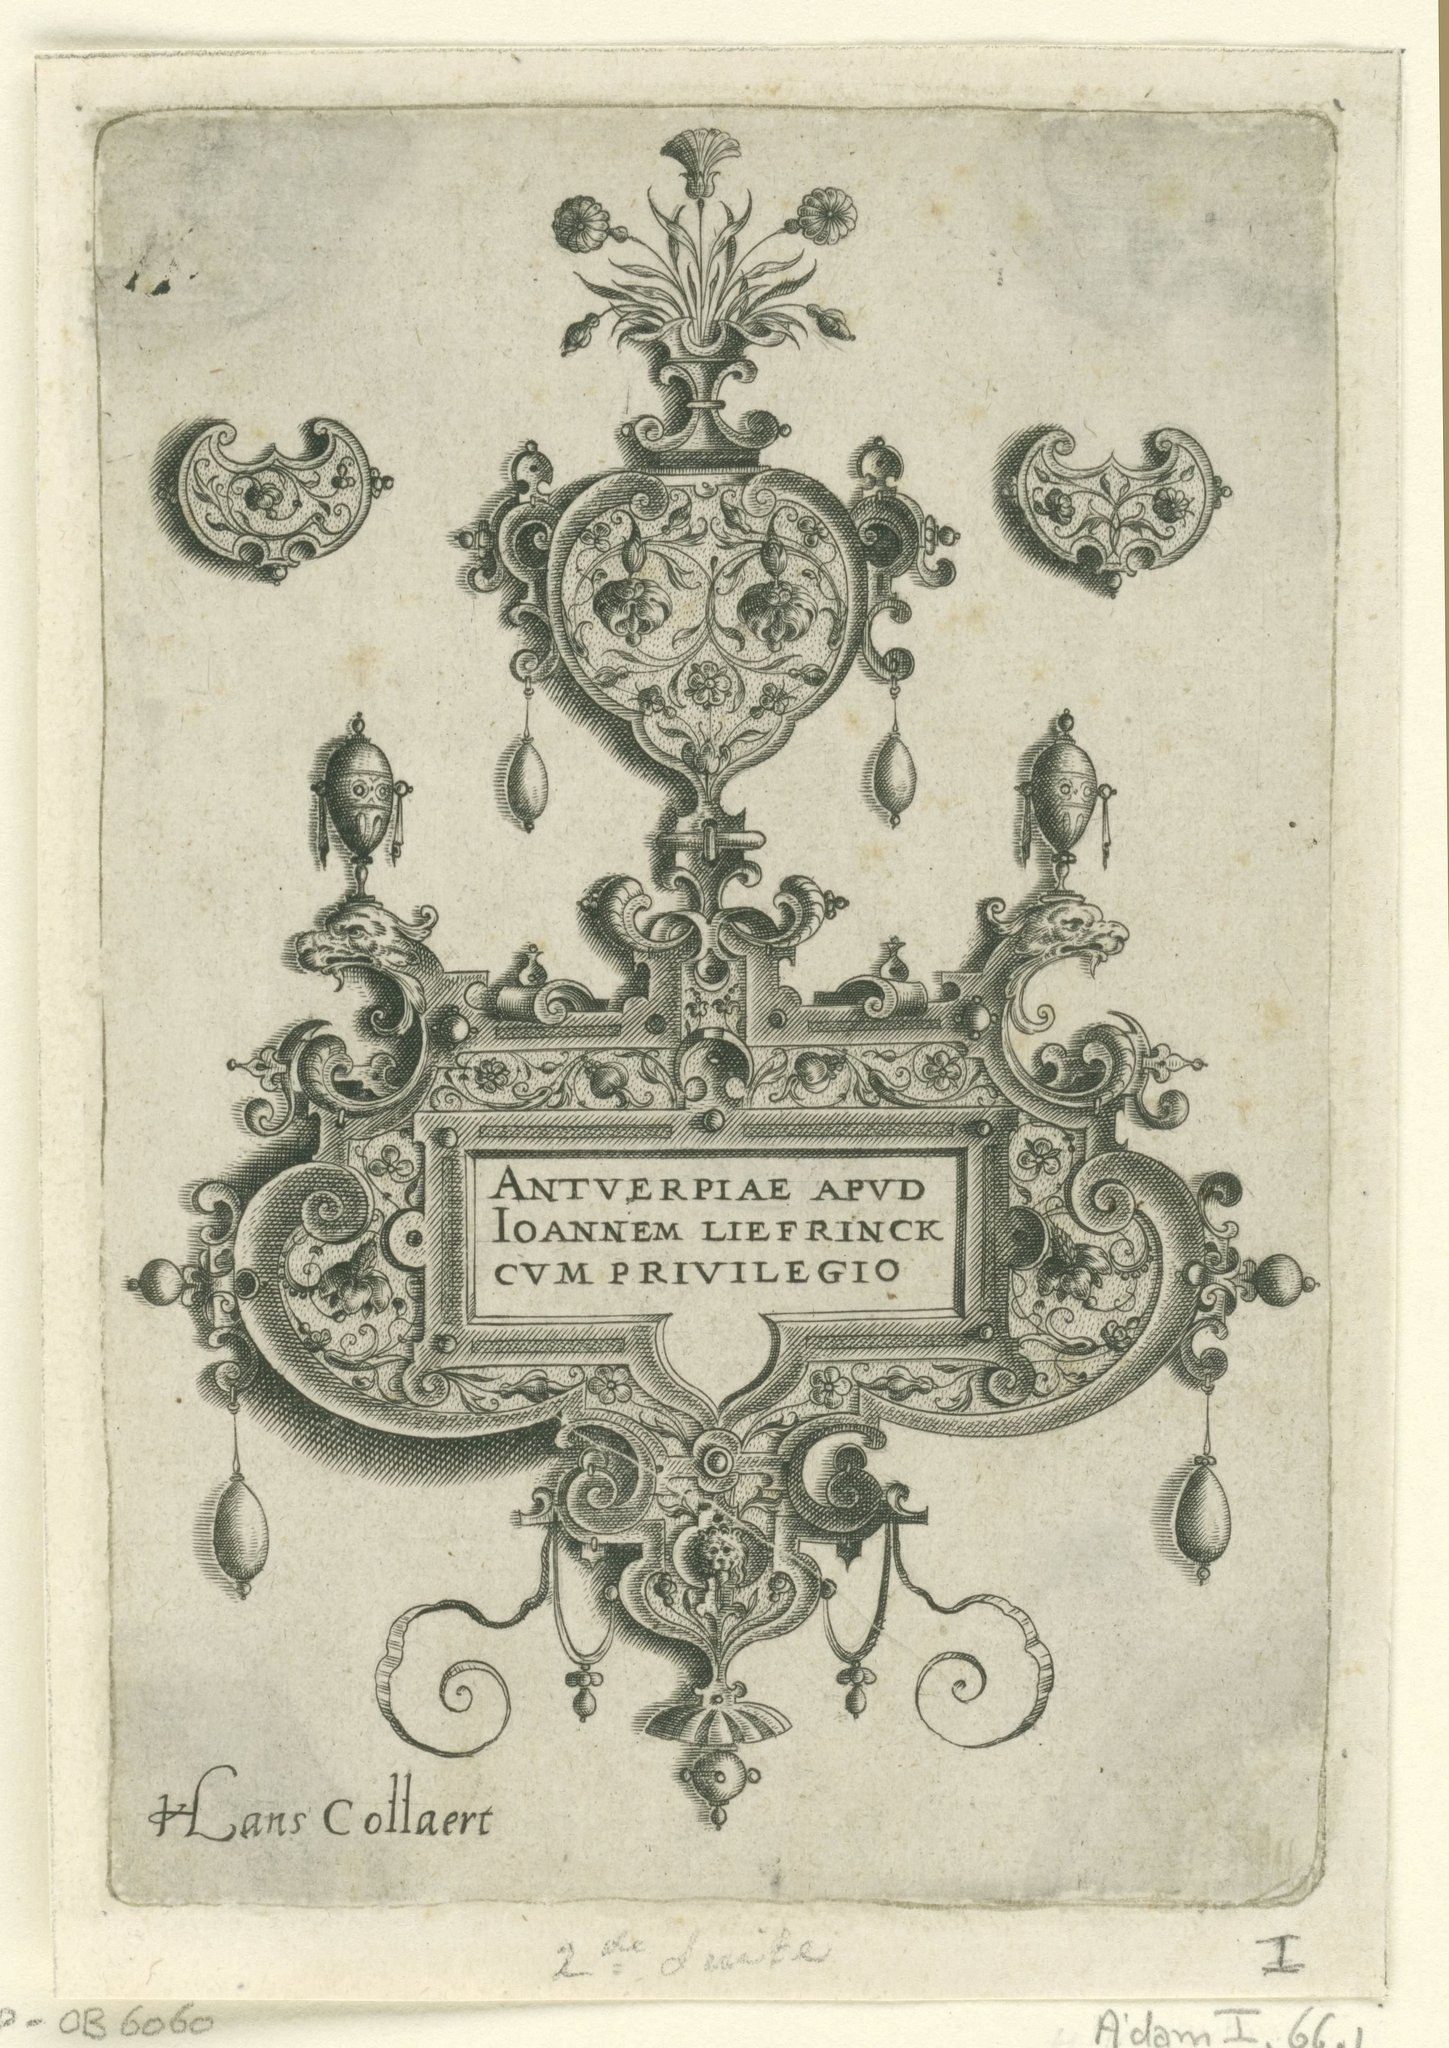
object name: ornament print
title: Hangers met arabesken en figuren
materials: paper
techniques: engraving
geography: netherlands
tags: pendant, trinket, 'breloque'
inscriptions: address: ‘ANTVERPIAE APUD / IOHANNEM LIEFRINCK / CUM PRIVILEGIO.’, signature: ‘Hans Collaert’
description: Dubbele hanger, bekroond door een boeket anjers. In het onderste deel van de hanger een cartouche met adres Hans Liefrinck in Antwerpen. Een van 6 bladen afkomstig uit een serie van 10 bladen met hangers. Aan iedere hanger hangen drie parels. Op elk blad bovendien nog twee of vier kleine kostuumornamenten.